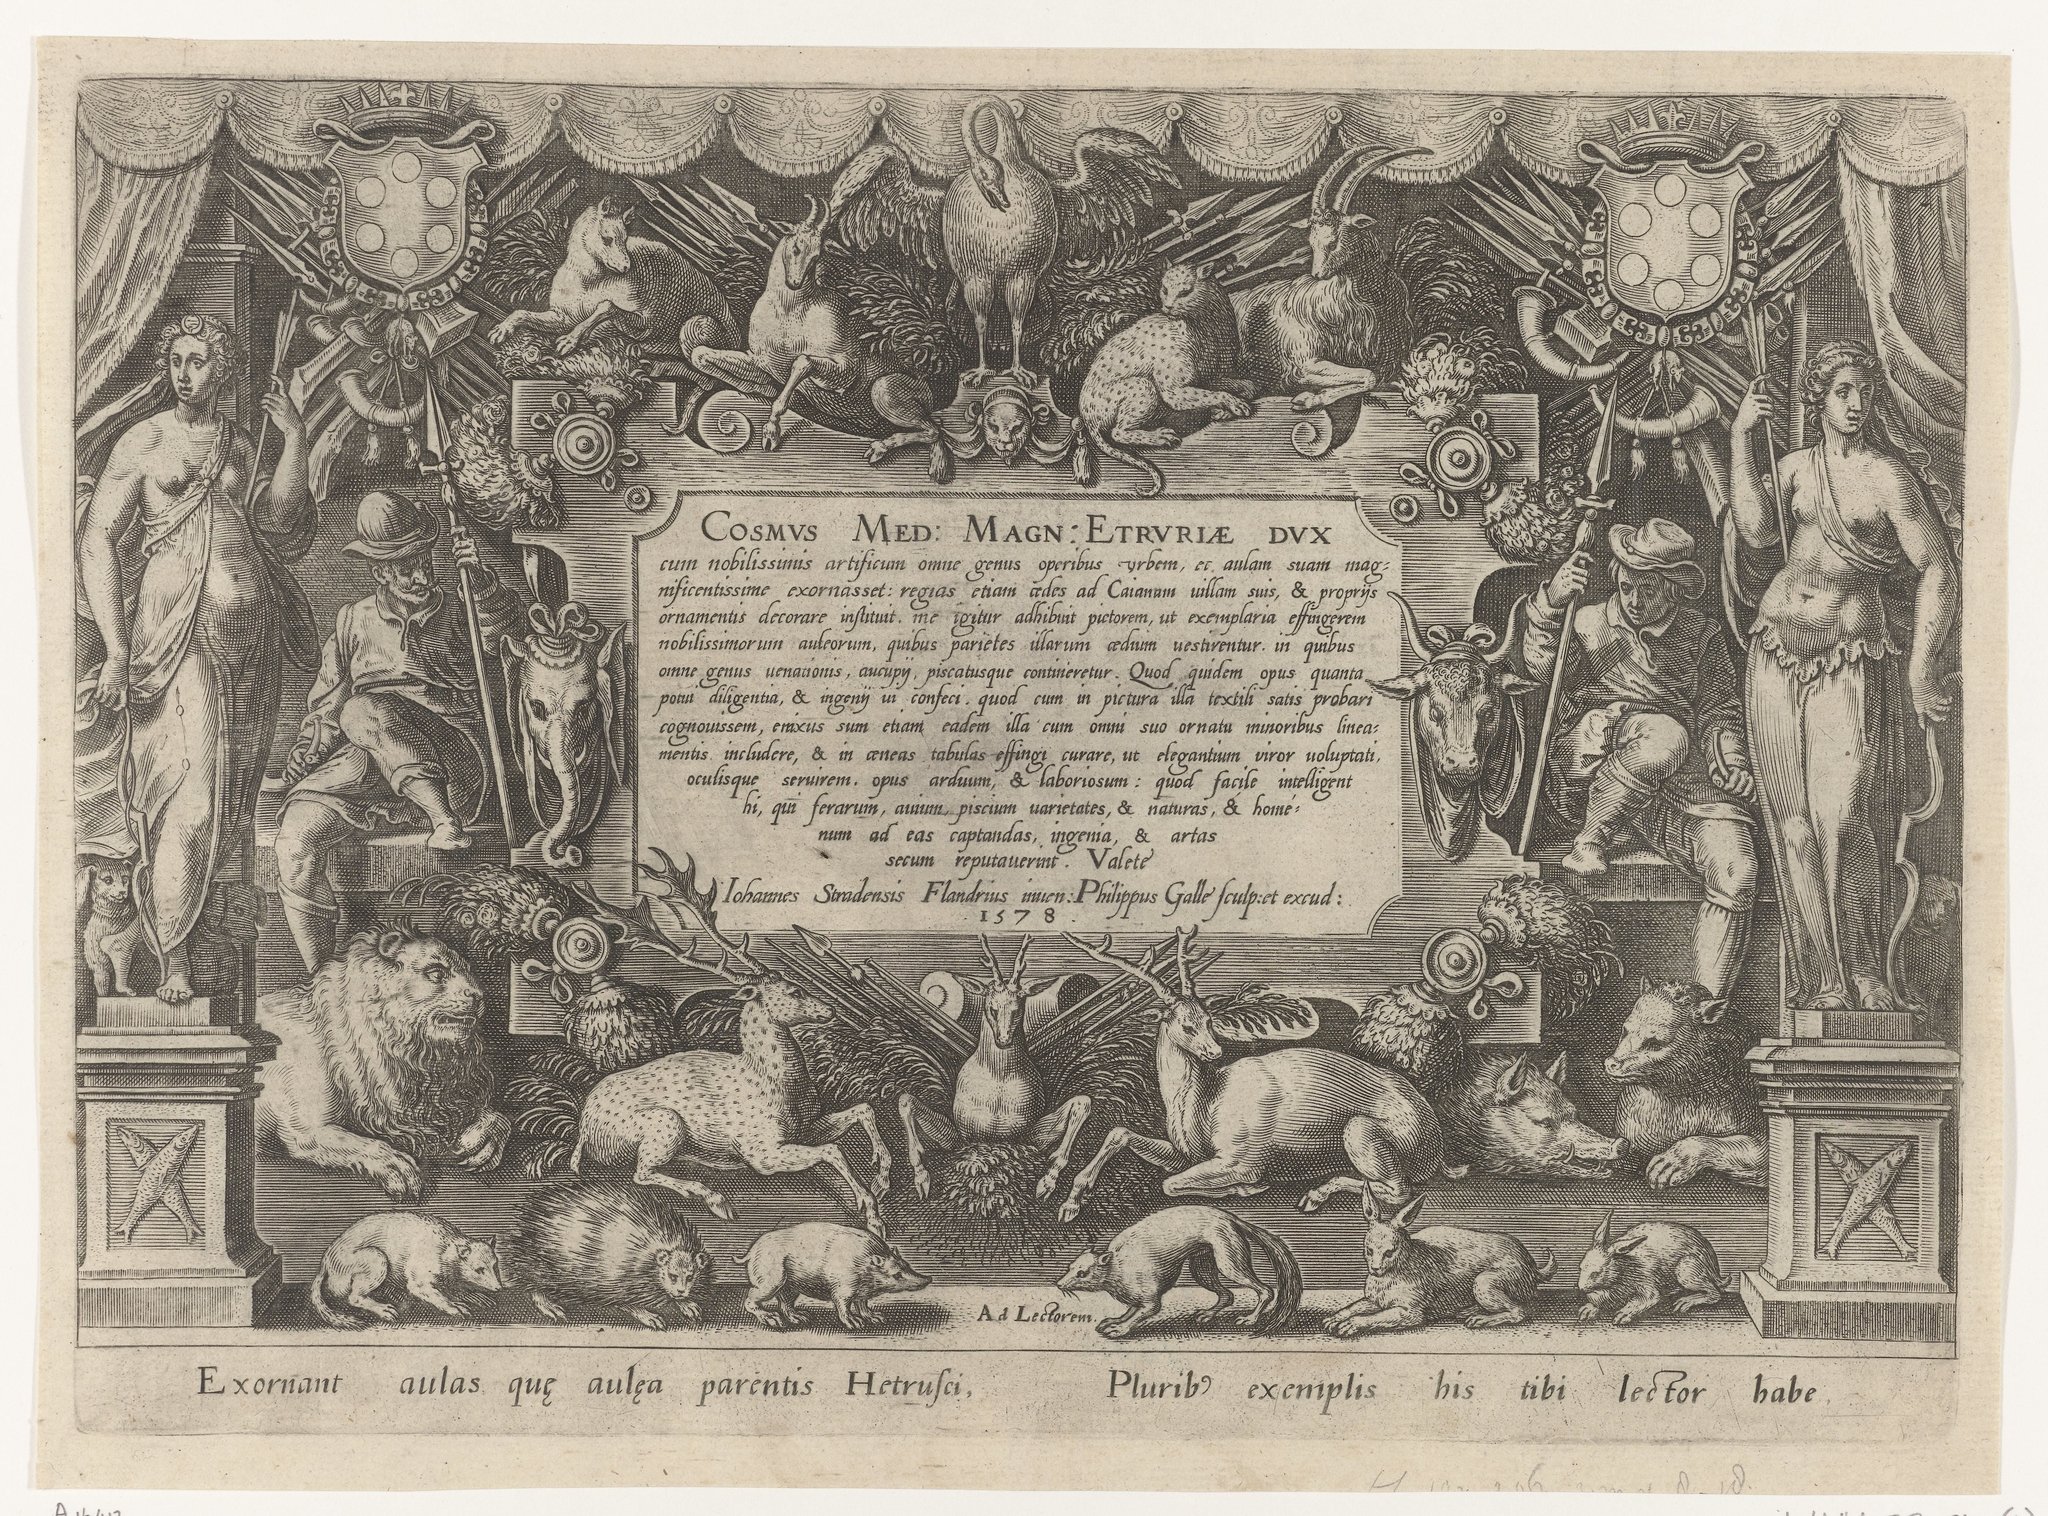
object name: print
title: Jachttaferelen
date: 1578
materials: paper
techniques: engraving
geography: florence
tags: animals, hunting, chase, hunter, title-page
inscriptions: collector's mark: Lugt 2228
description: Titelblad van serie van 43 prenten met jachttaferelen. De cartouche met de Latijnse titel wordt omgeven door een brede rand van dieren en links en rechts een zittende jager. Op sokkels links en rechts een staande vrouwenfiguur in antiek gewaad met pijl en boog. Bovenaan links en rechts het wapen van de Medici-familie.